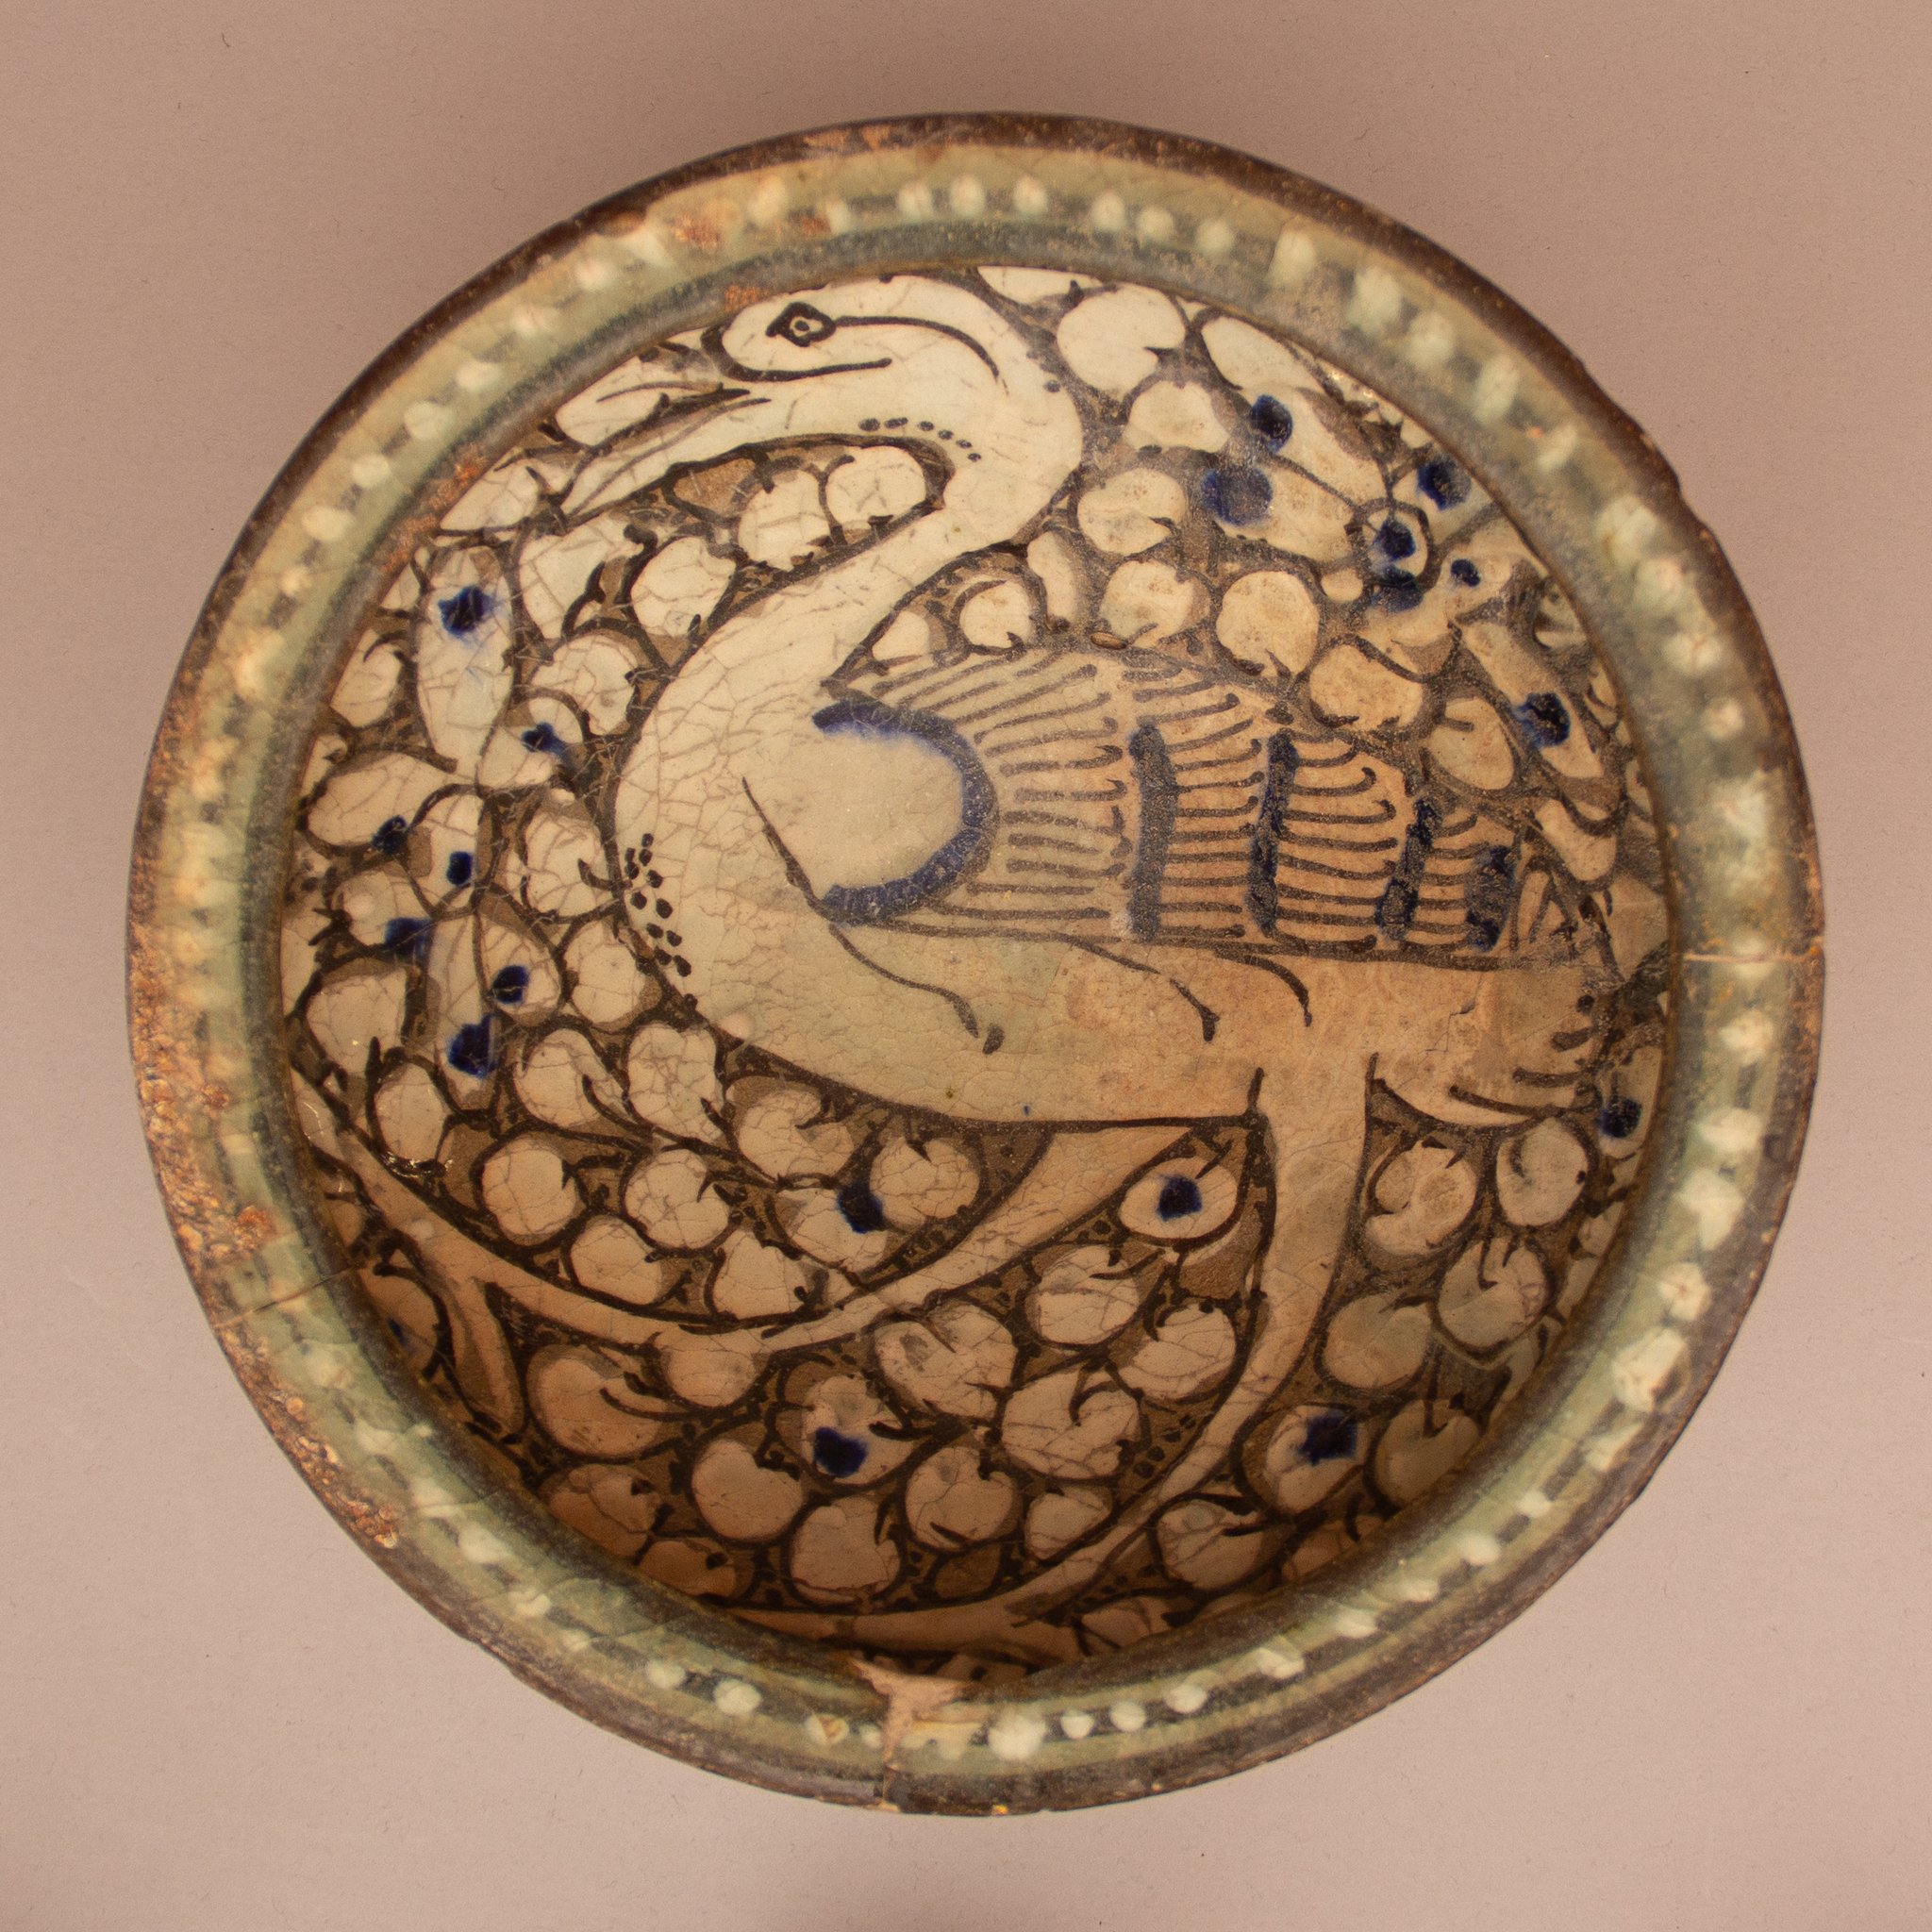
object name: bowl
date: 1301-1350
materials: stonepaste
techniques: painting, underglaze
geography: iran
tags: birds